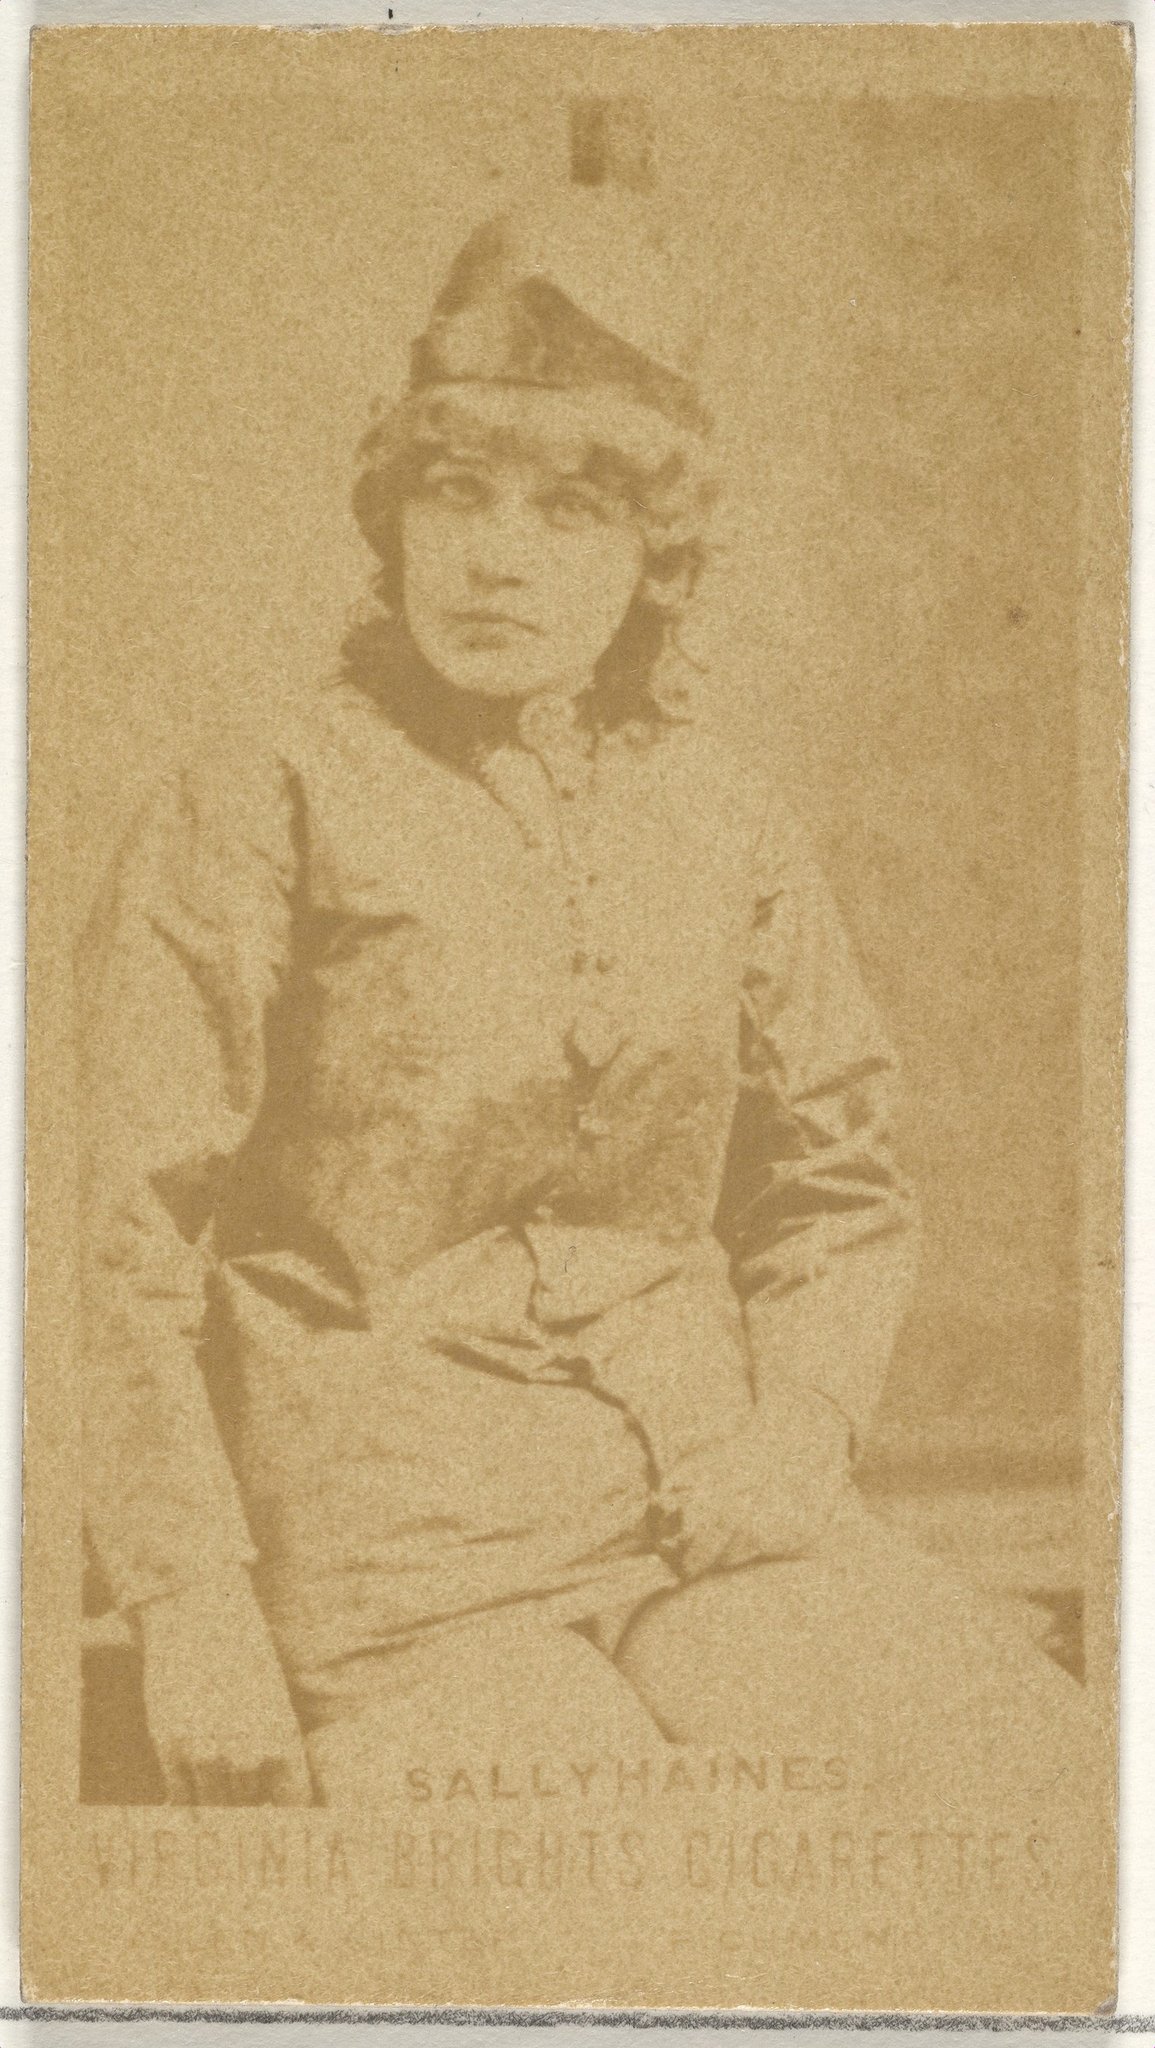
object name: photograph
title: Sally Haines, from the Actors and Actresses series (N45, Type 1) for Virginia Brights Cigarettes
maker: allen & ginter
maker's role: publisher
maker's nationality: american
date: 1888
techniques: albumen silver print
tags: portraits,women,actresses